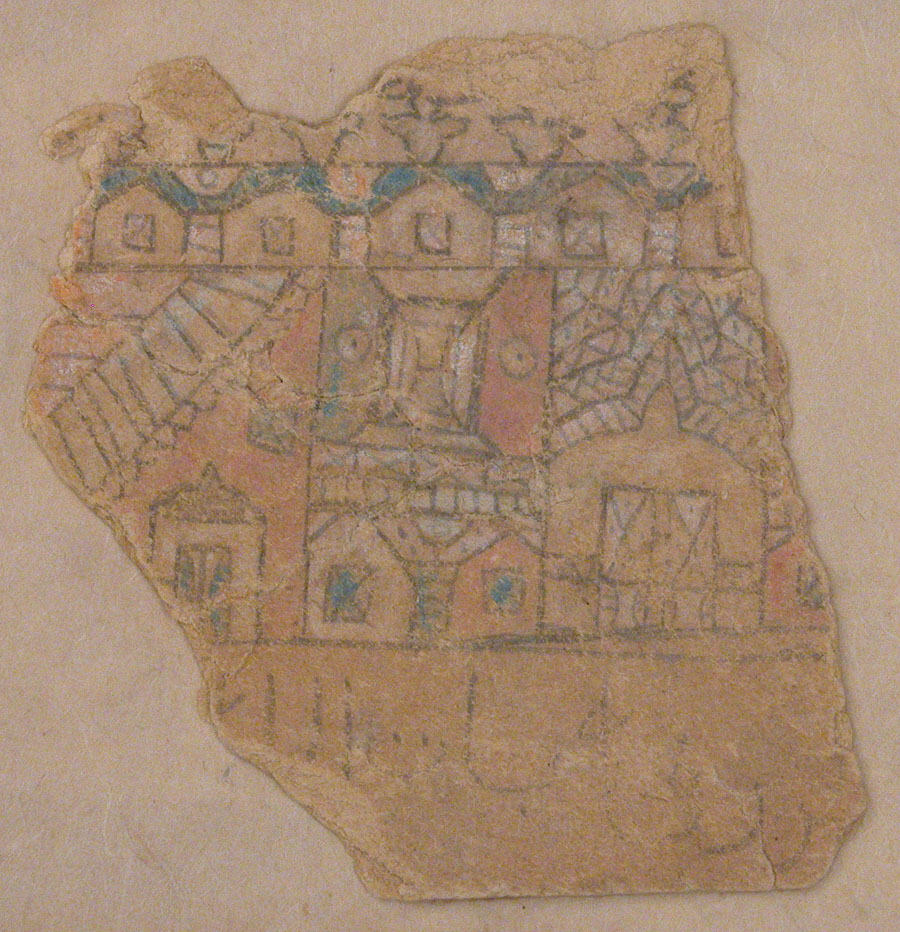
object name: illustrated album leaf or single work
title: Building Complex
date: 1501-1600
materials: chalk, ink, paper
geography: egypt